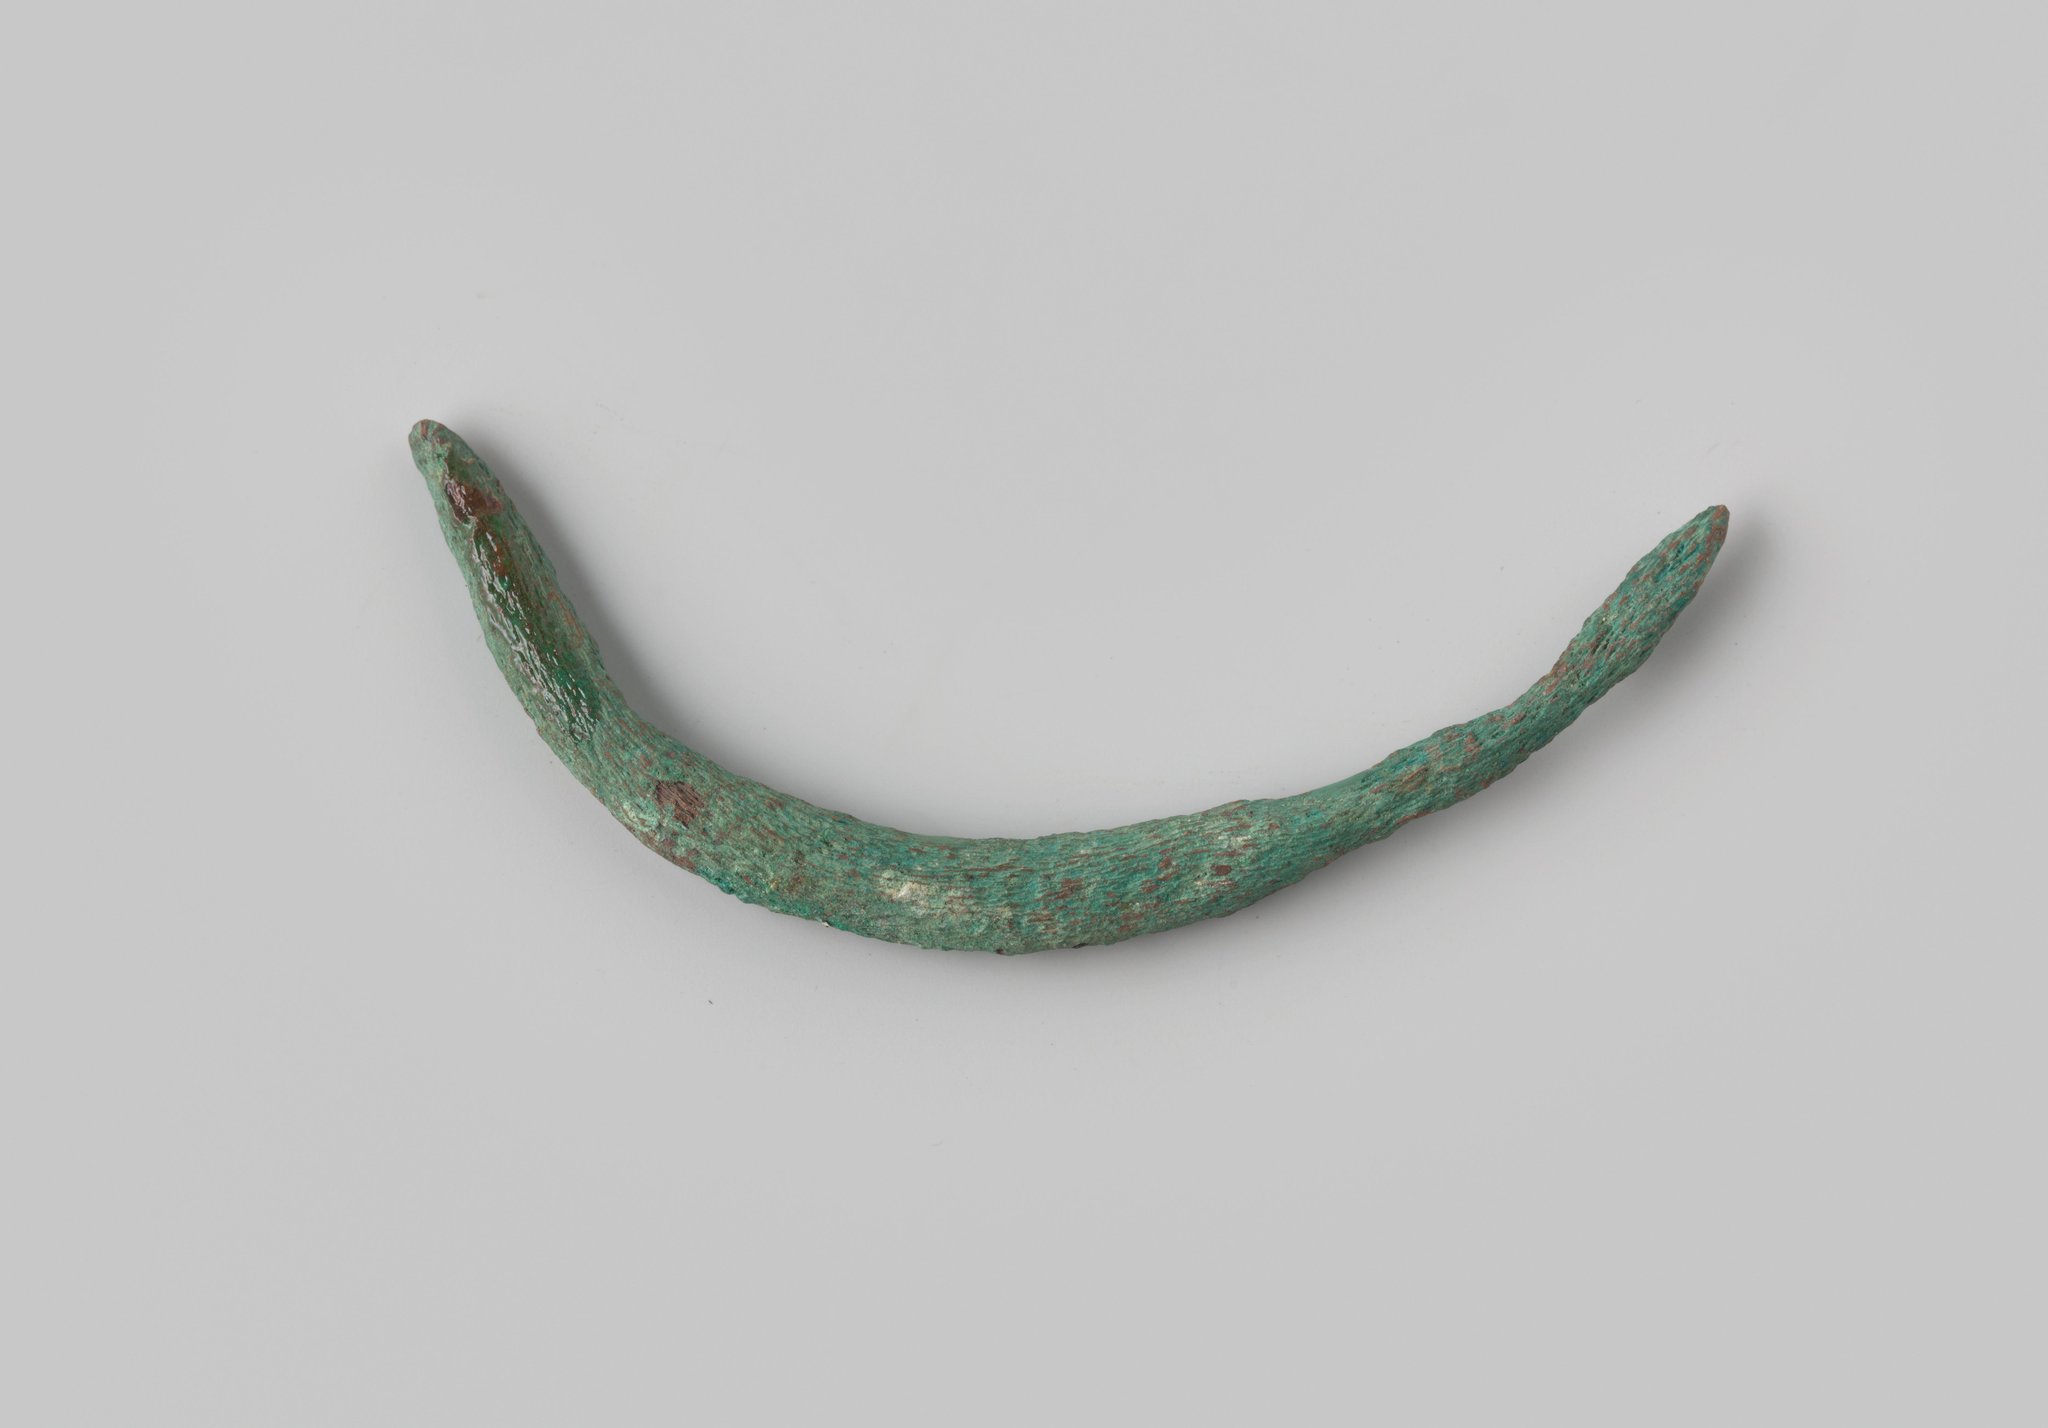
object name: beugel gevestl, gevestbeugel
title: Beugel van gevest uit het wrak van de Oost-Indiëvaarder Hollandia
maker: Anonymous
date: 1700-1743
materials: copper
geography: netherlands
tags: verenigde oostindische compagnie, hollandia (schip), annet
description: Hilt, guard, fragm of knuckle-guard, heavily eroded, no decoration visible, sim. NG 1980-27H2702.